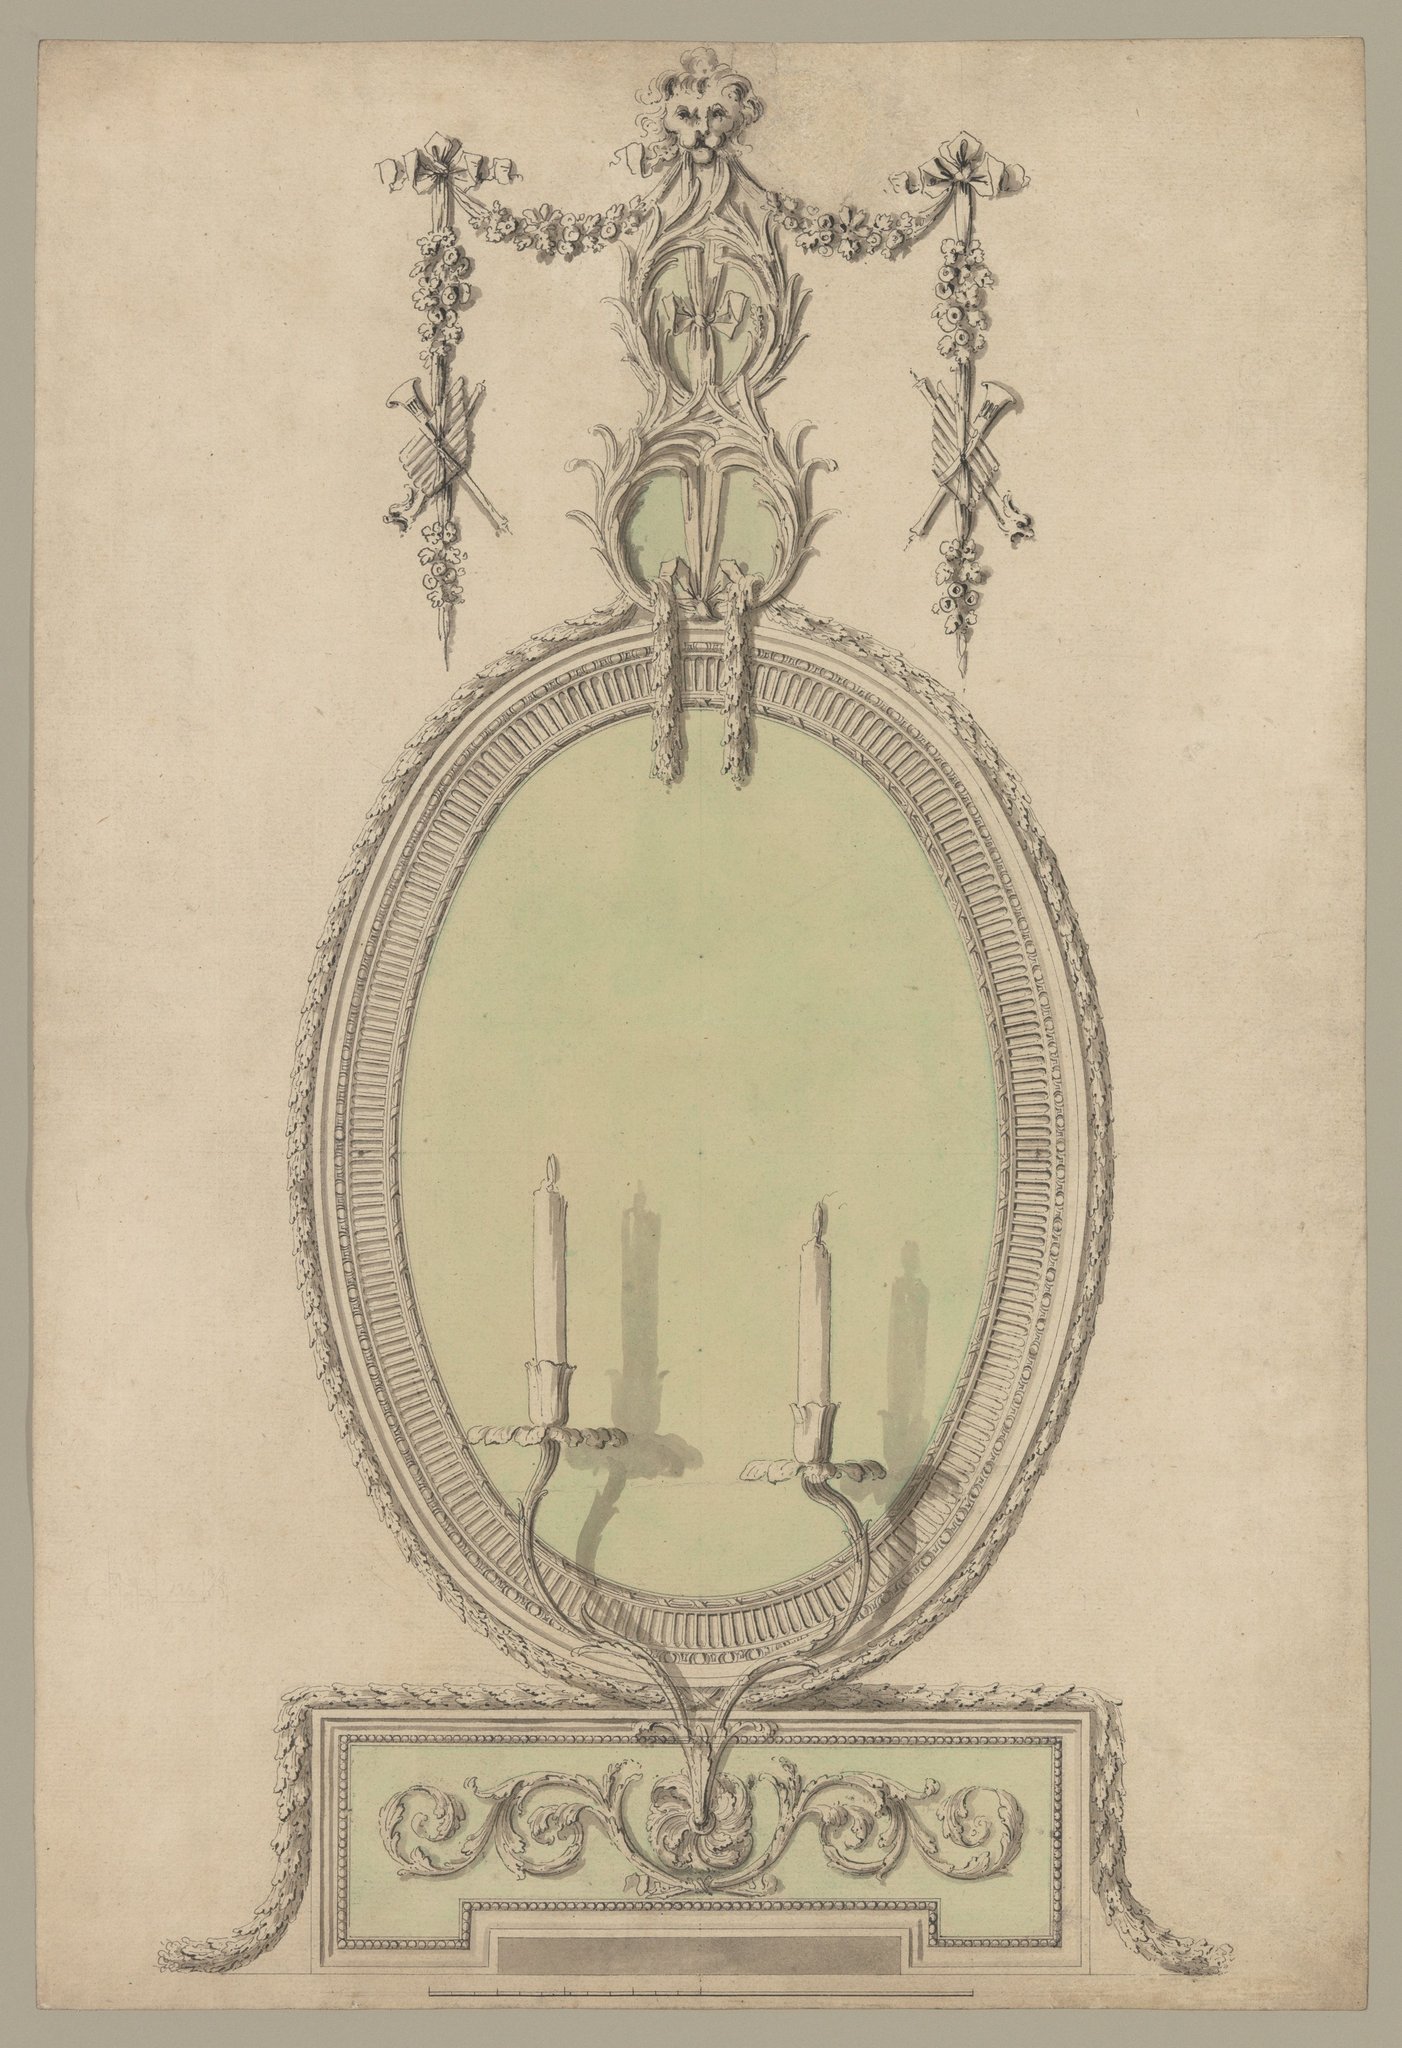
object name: drawing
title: Two Designs for an Overmantel Glass (Verso: Partial Floor plan)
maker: sir william chambers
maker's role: artist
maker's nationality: british, born sweden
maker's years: 1723-1796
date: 1743-1796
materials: graphite, ink, watercolor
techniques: brush, pen, wash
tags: mirrors